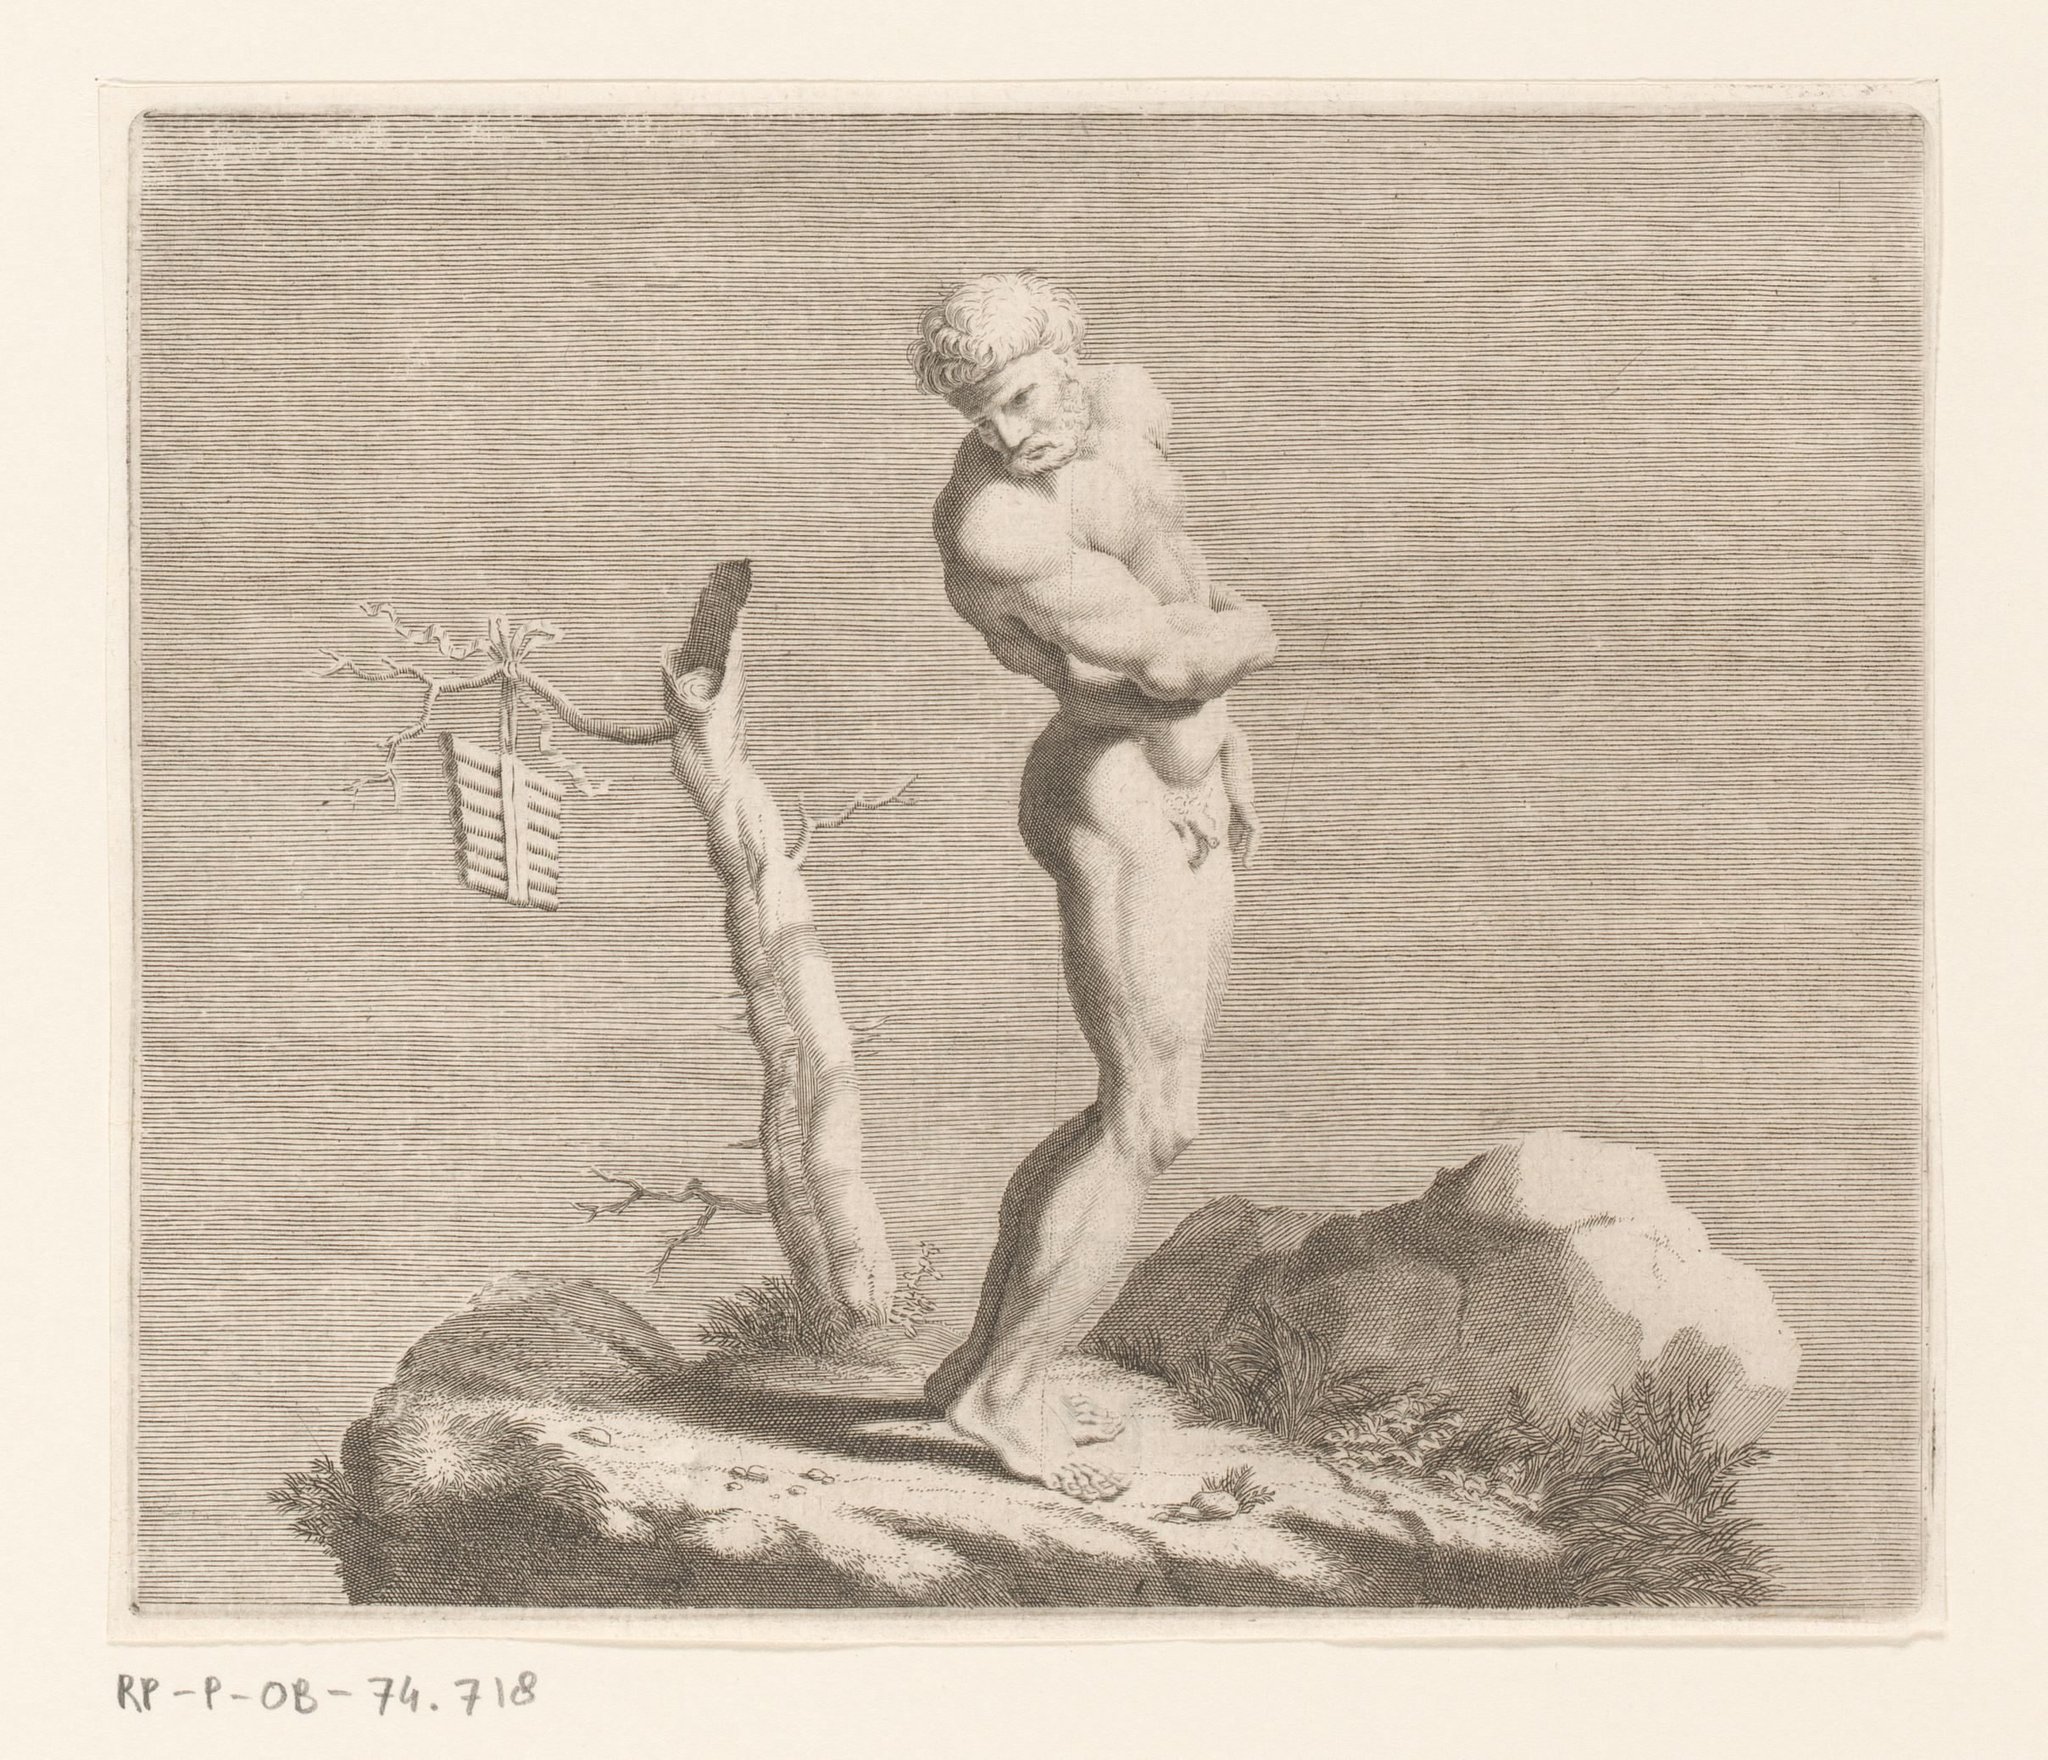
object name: print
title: Naakte man, mogelijk Pan, bij een boomstronk met panfluit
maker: Anonymous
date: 1600-1699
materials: paper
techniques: engraving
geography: france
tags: panpipes, (story of) pan, man (showing himself) undressed, quasi-nude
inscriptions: collector's mark: Lugt 2228